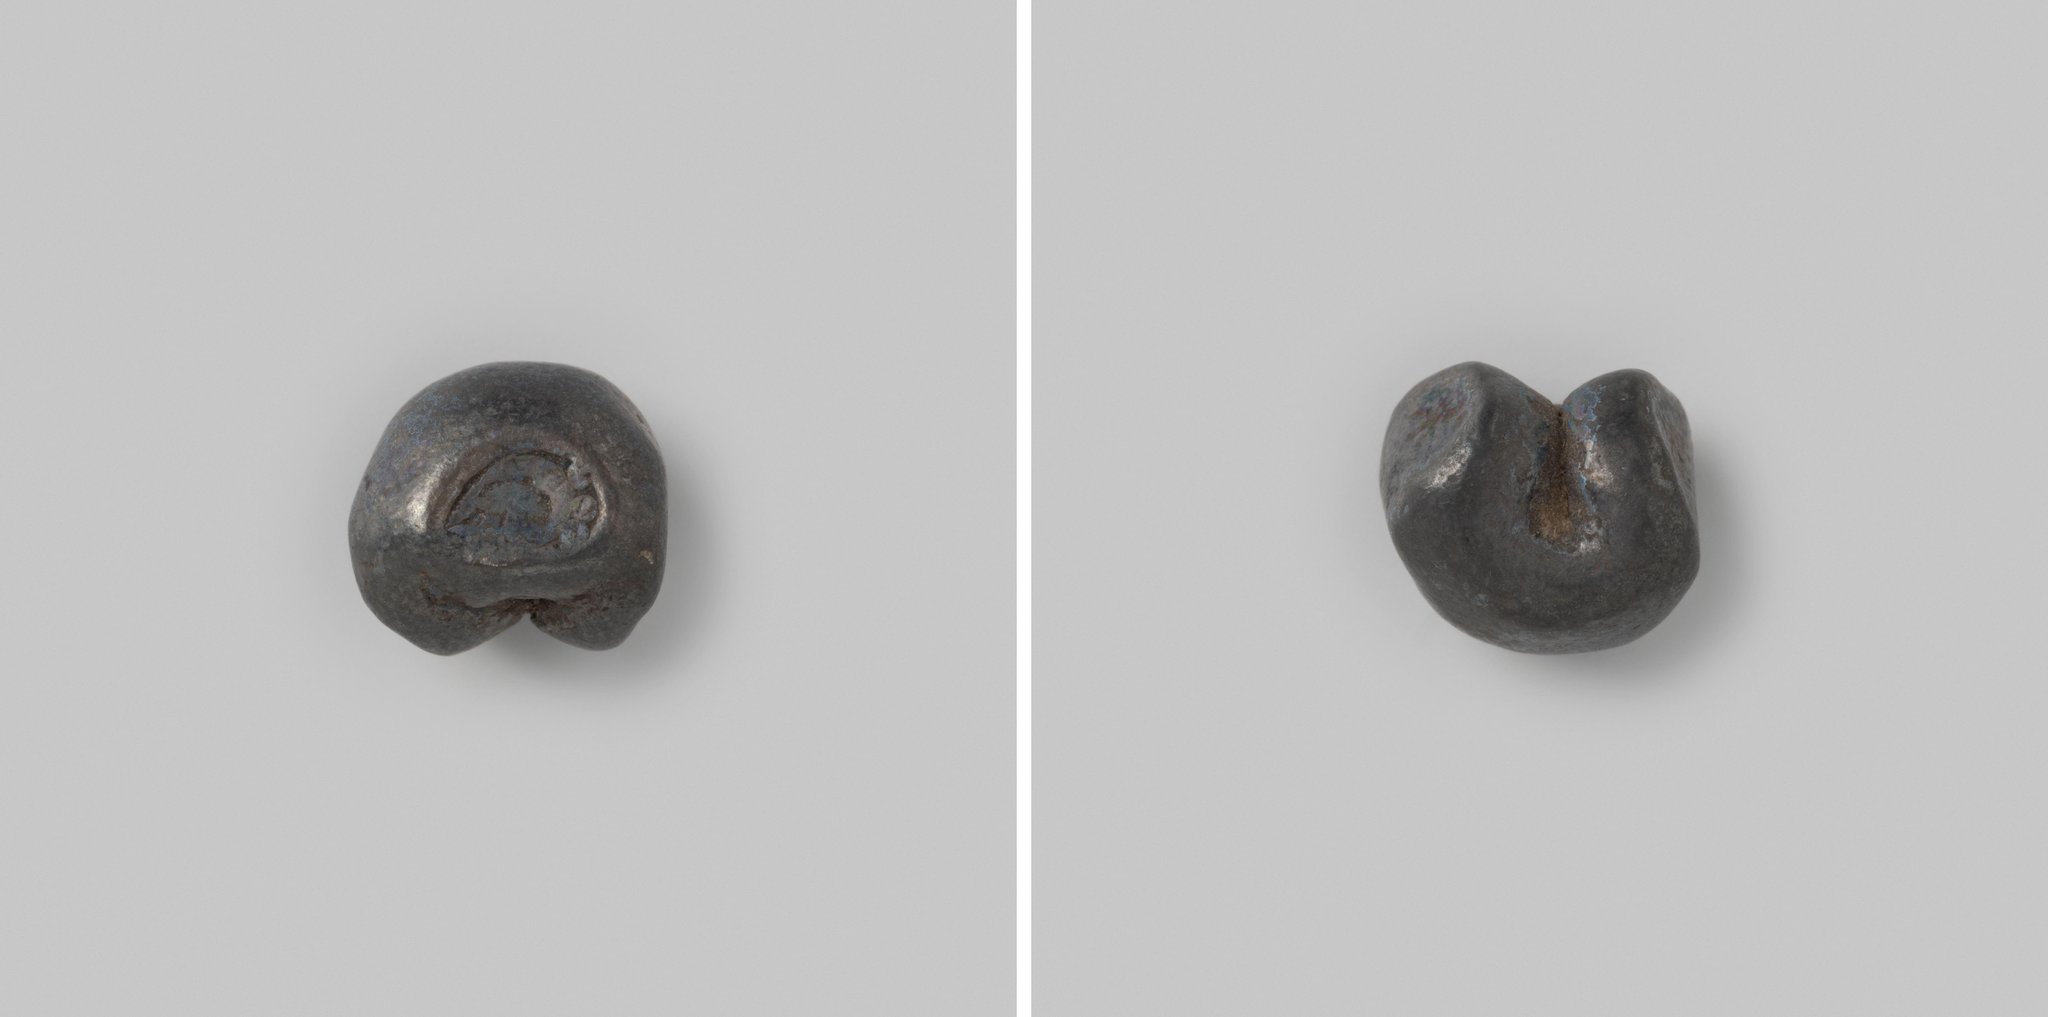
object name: coin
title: Thailand,1/4 tical of salung,1650-1850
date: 1650-1850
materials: silver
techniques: casting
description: Zilveren, korrelvormige munt. voorzien van één, onduidelijke instempeling (kra).